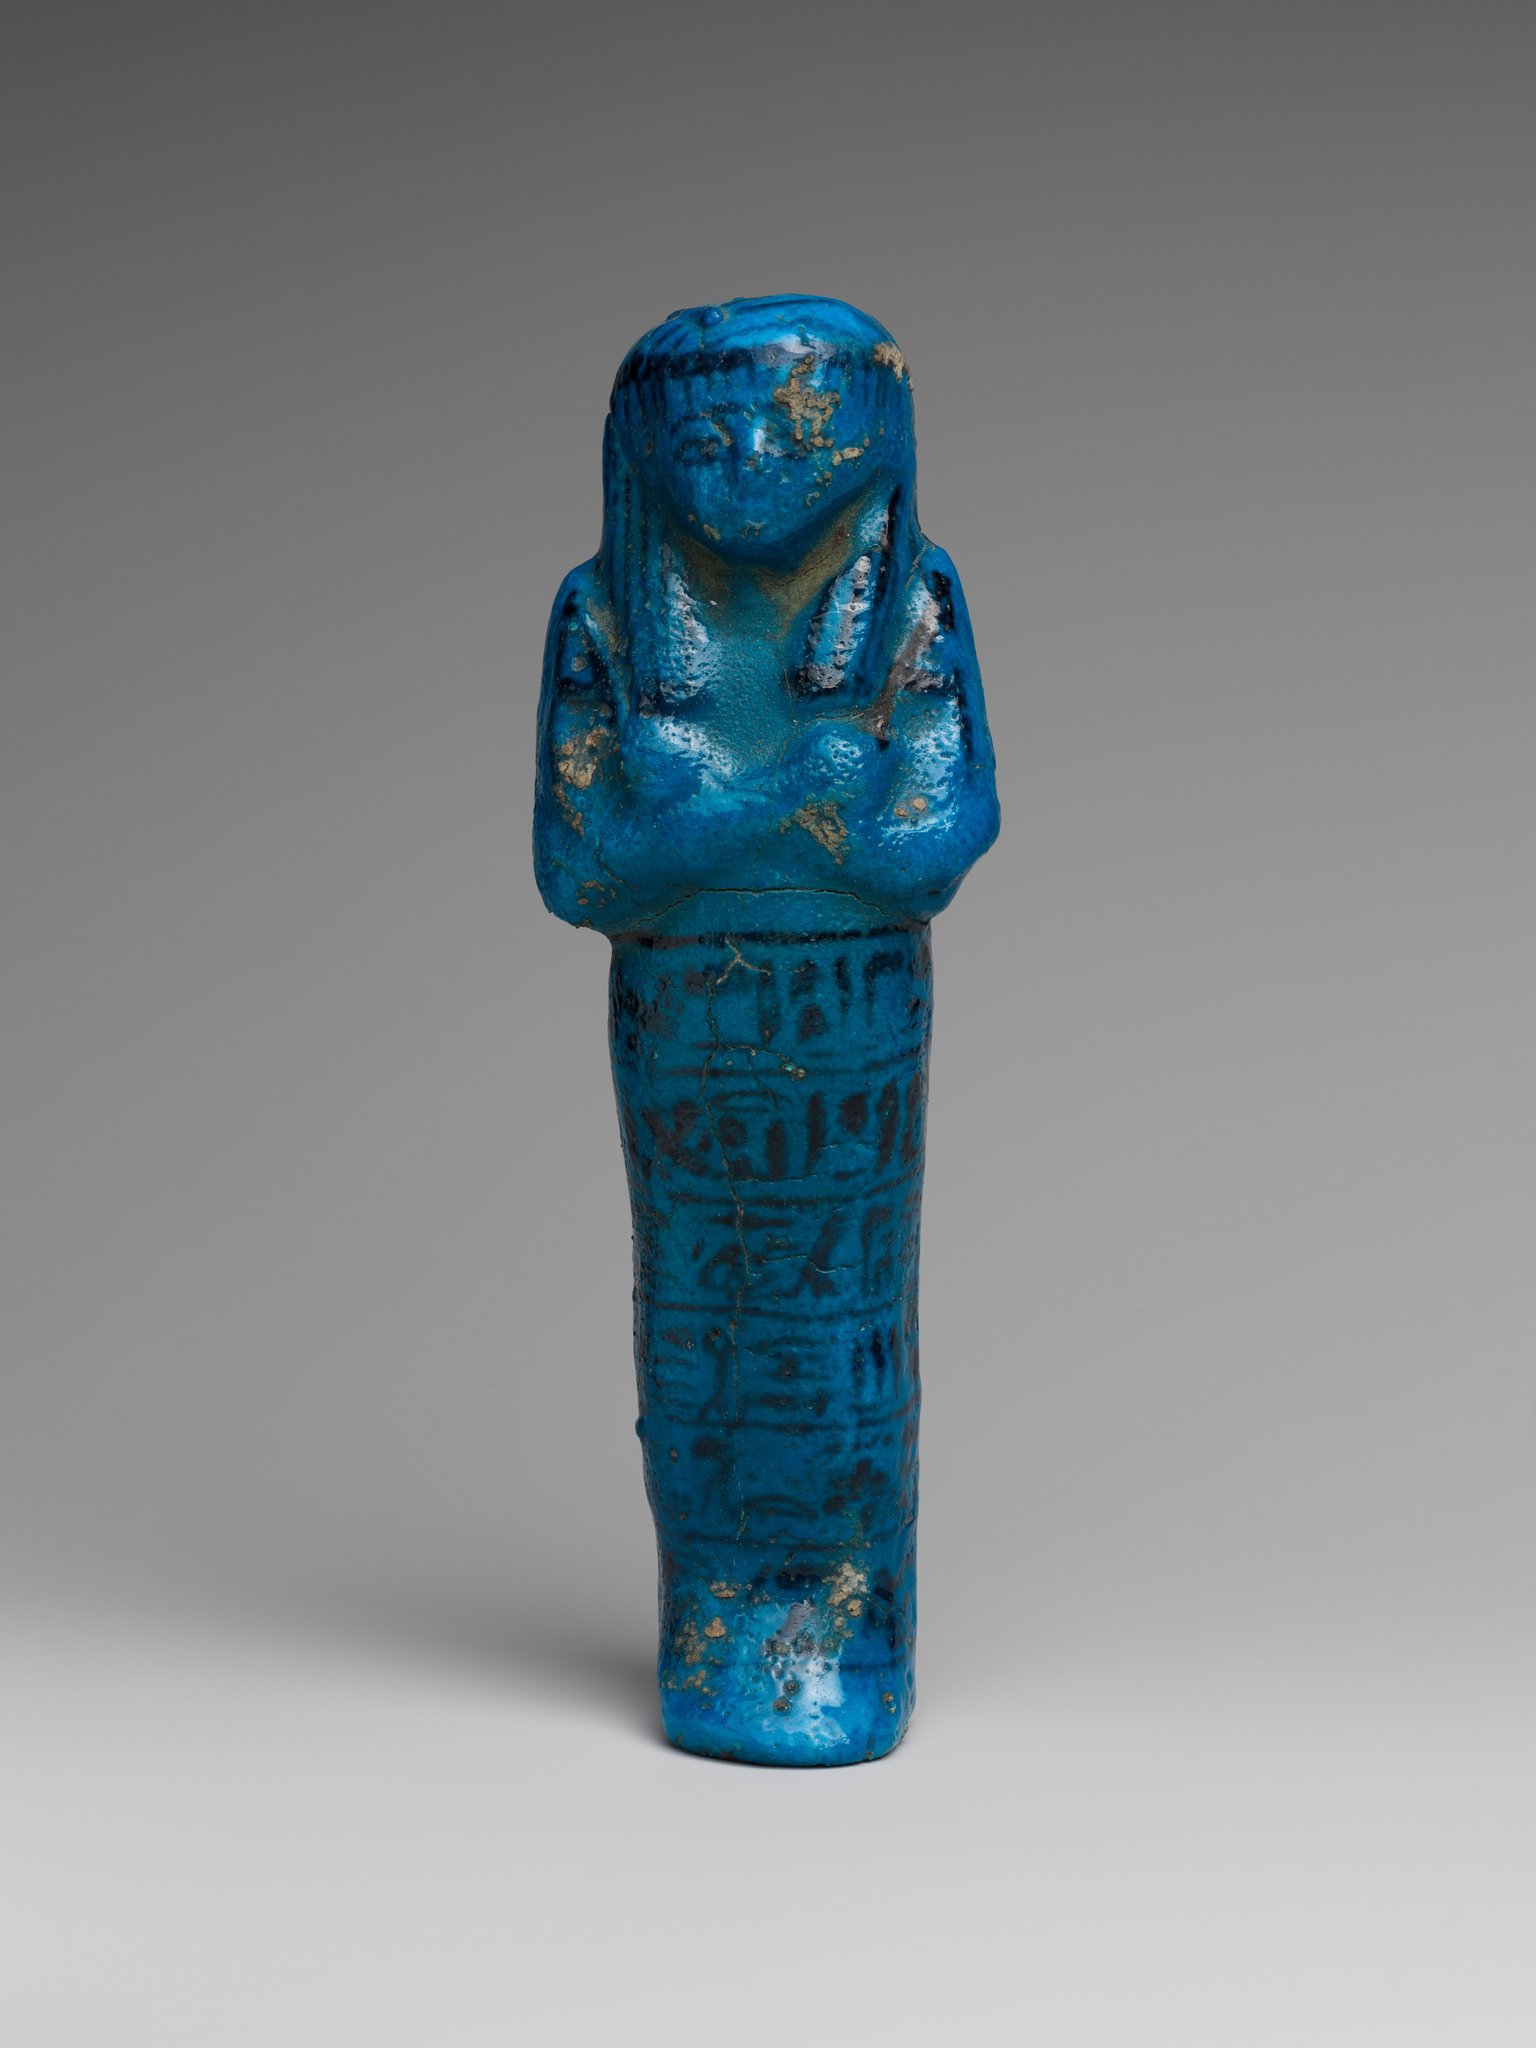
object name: shabti, painedjem ii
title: Shabti of the High Priest of Amun, Painedjem II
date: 988-966 BCE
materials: faience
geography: upper egypt, thebes